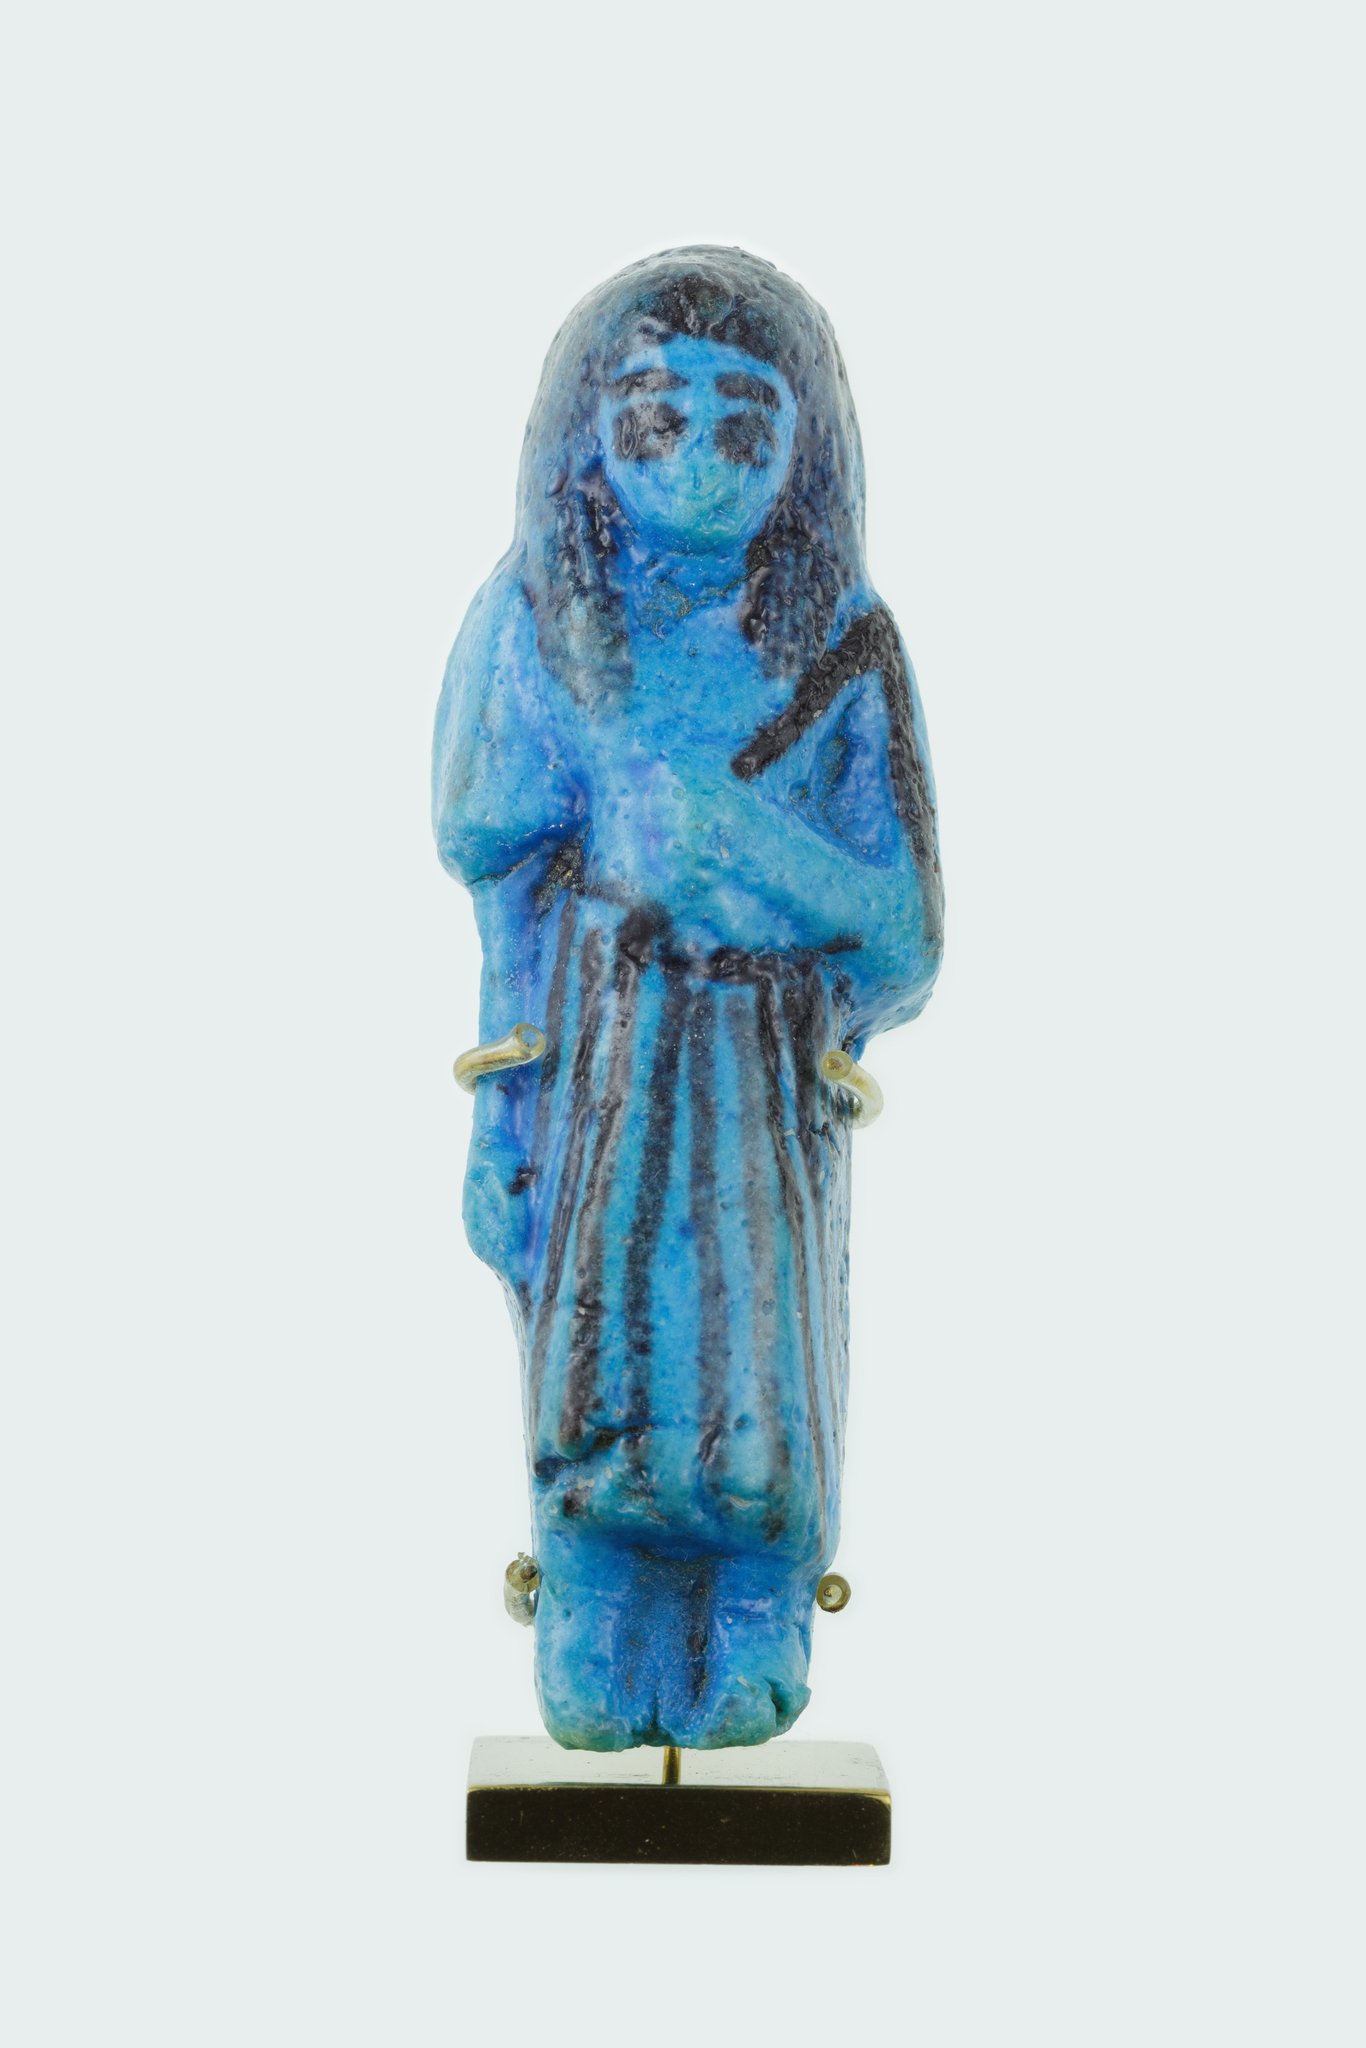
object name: shabti, overseer, nauny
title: Overseer Shabti of Nauny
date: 1050 BCE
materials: faience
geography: egypt